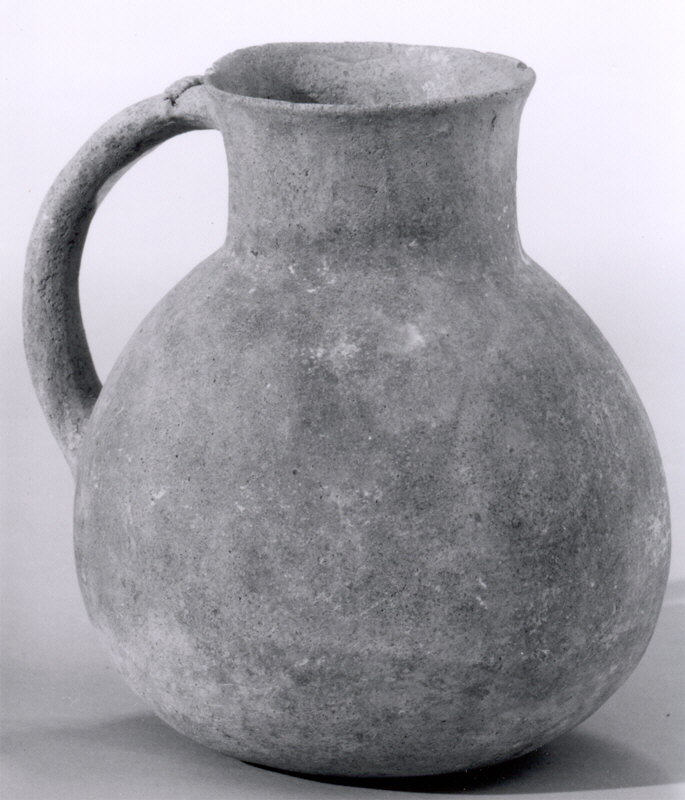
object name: jar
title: Jar with loop handle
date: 3500-3300 BCE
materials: ceramic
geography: levant